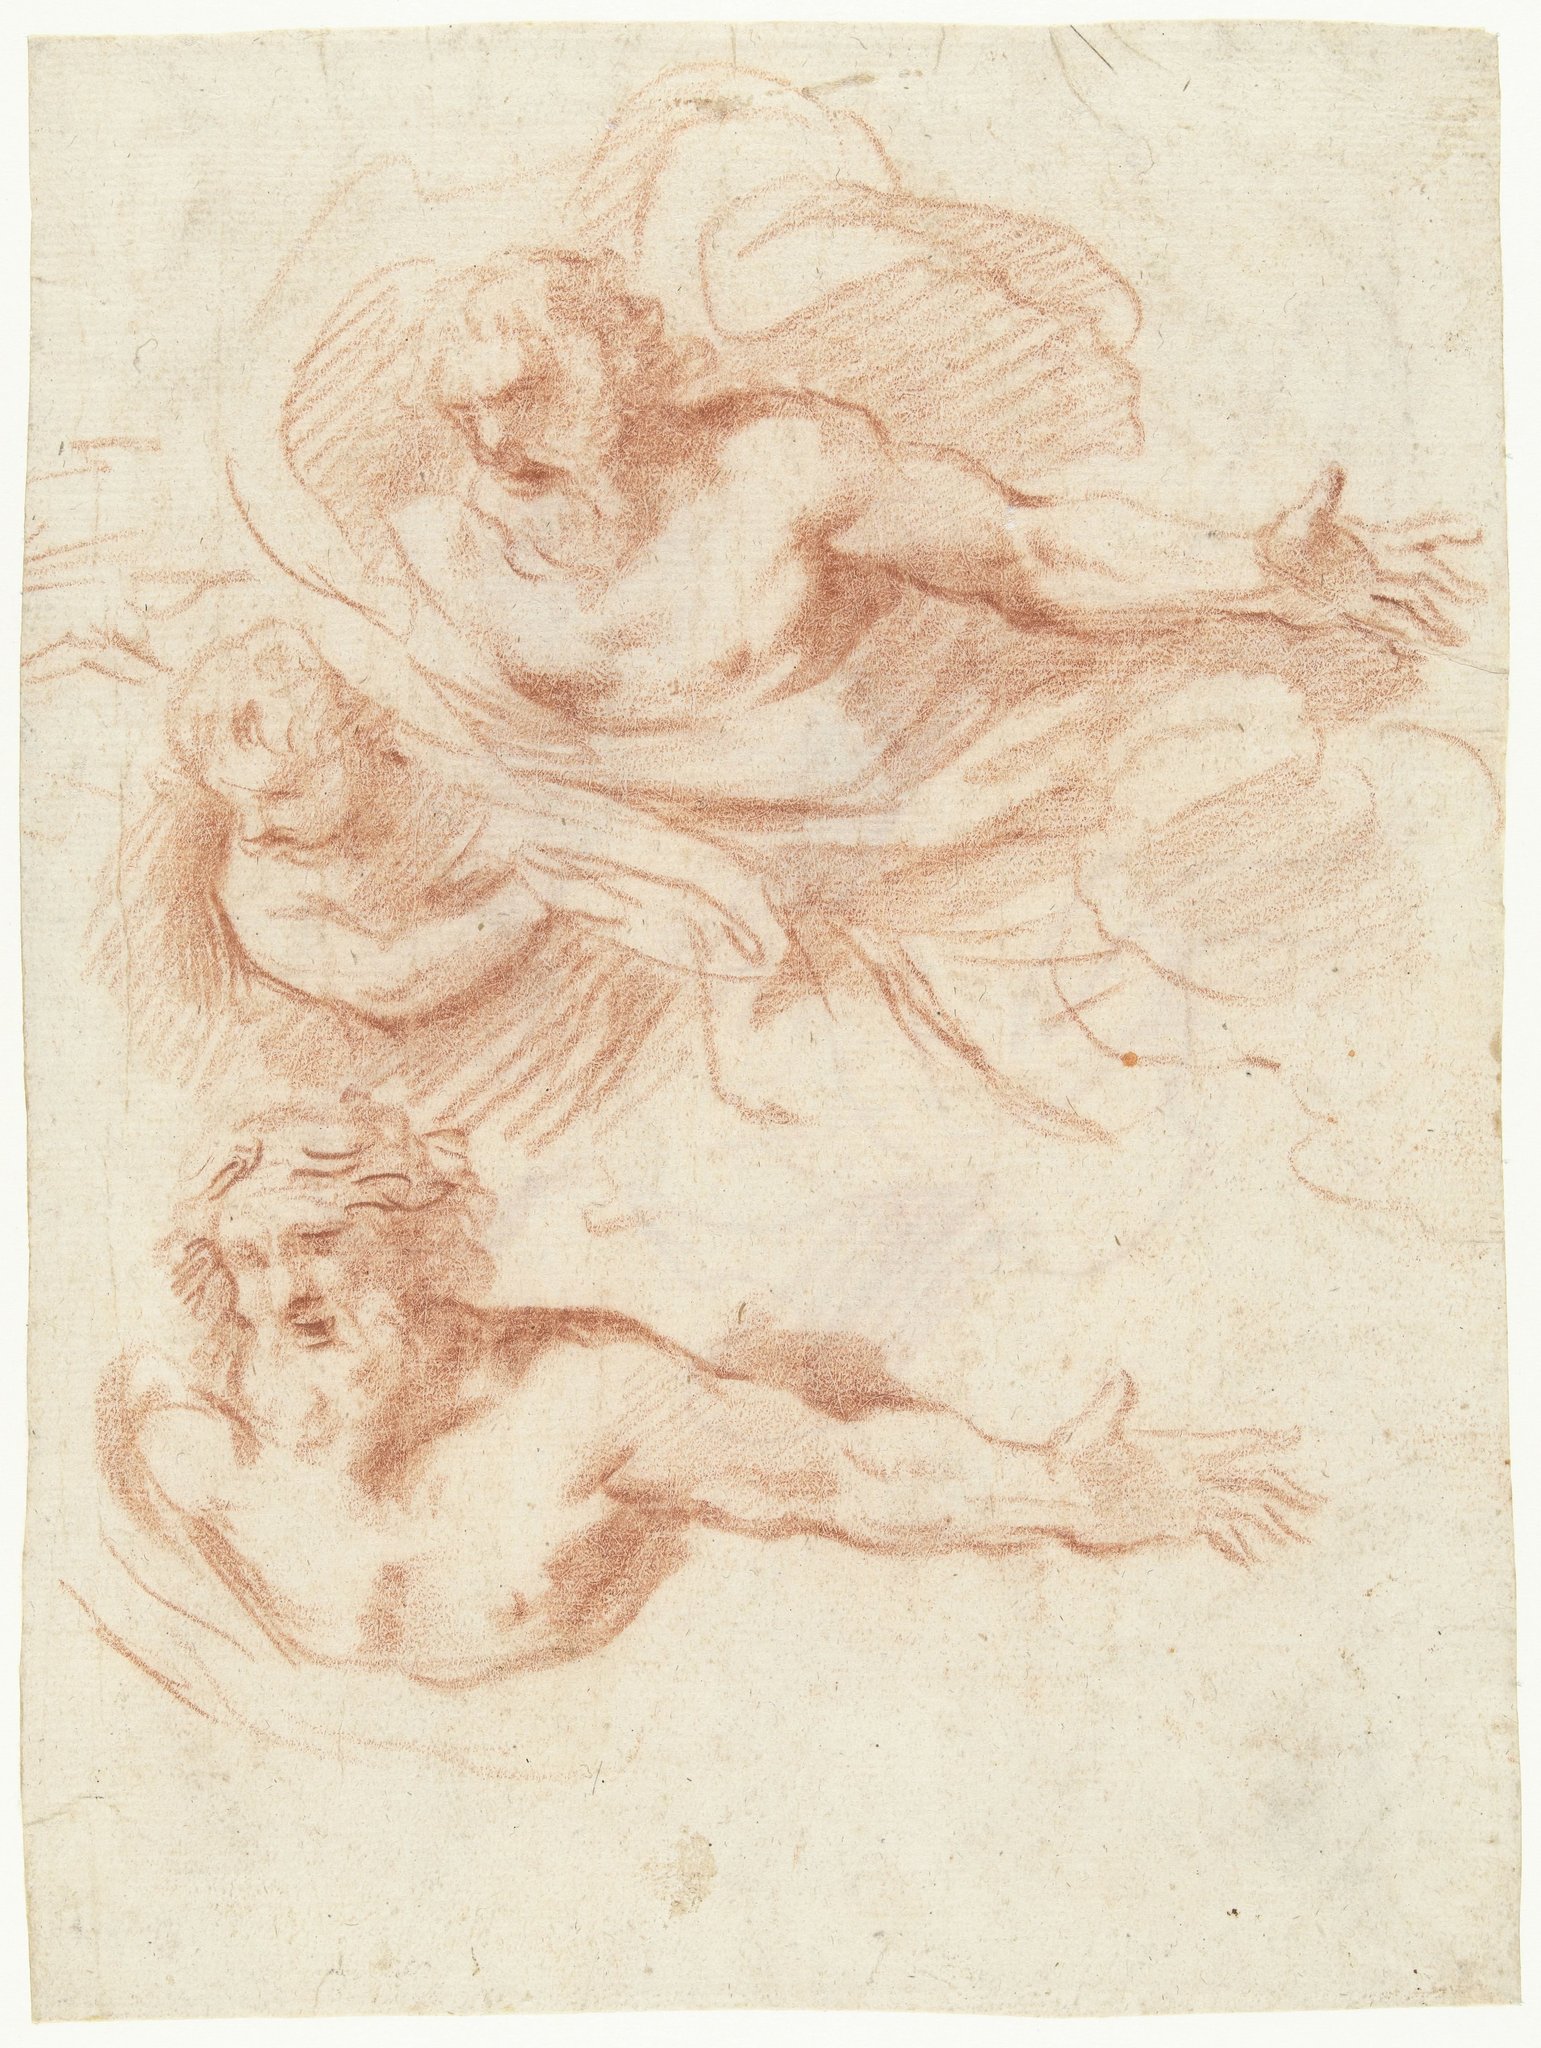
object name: drawing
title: Twee studies voor een aanzwevende God de Vader, boven elkaar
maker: guglielmo cortese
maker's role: draughtsman, painter, print maker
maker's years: 1628-1679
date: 1664-1666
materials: chalk, paper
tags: god the father as bearded old man, usually with crown or tiara or sceptre and/or globe